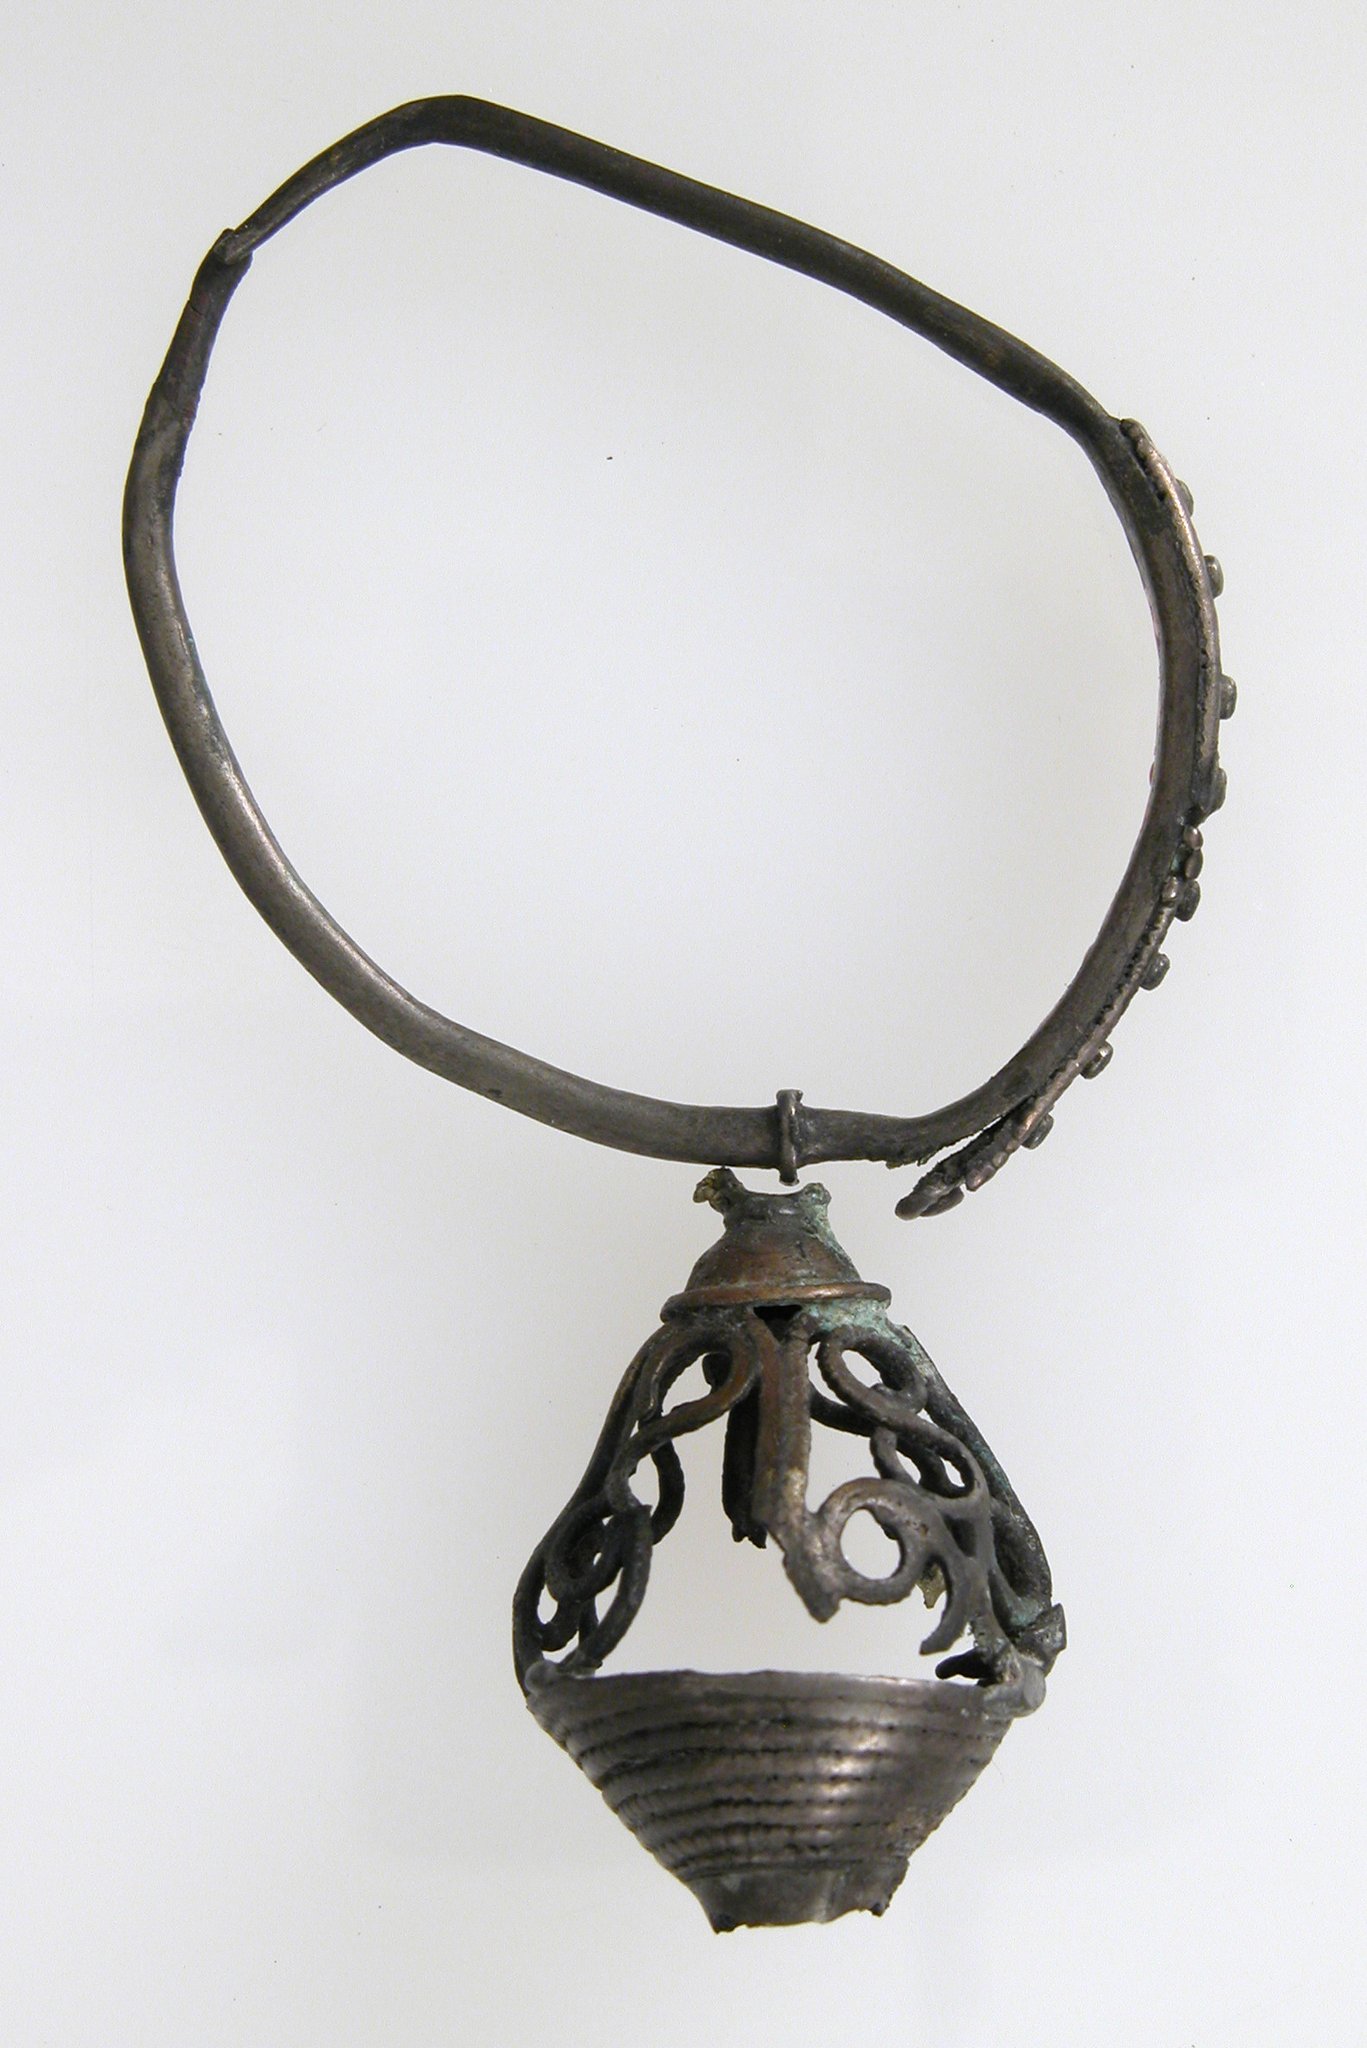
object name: earring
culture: avar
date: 701-900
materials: silver